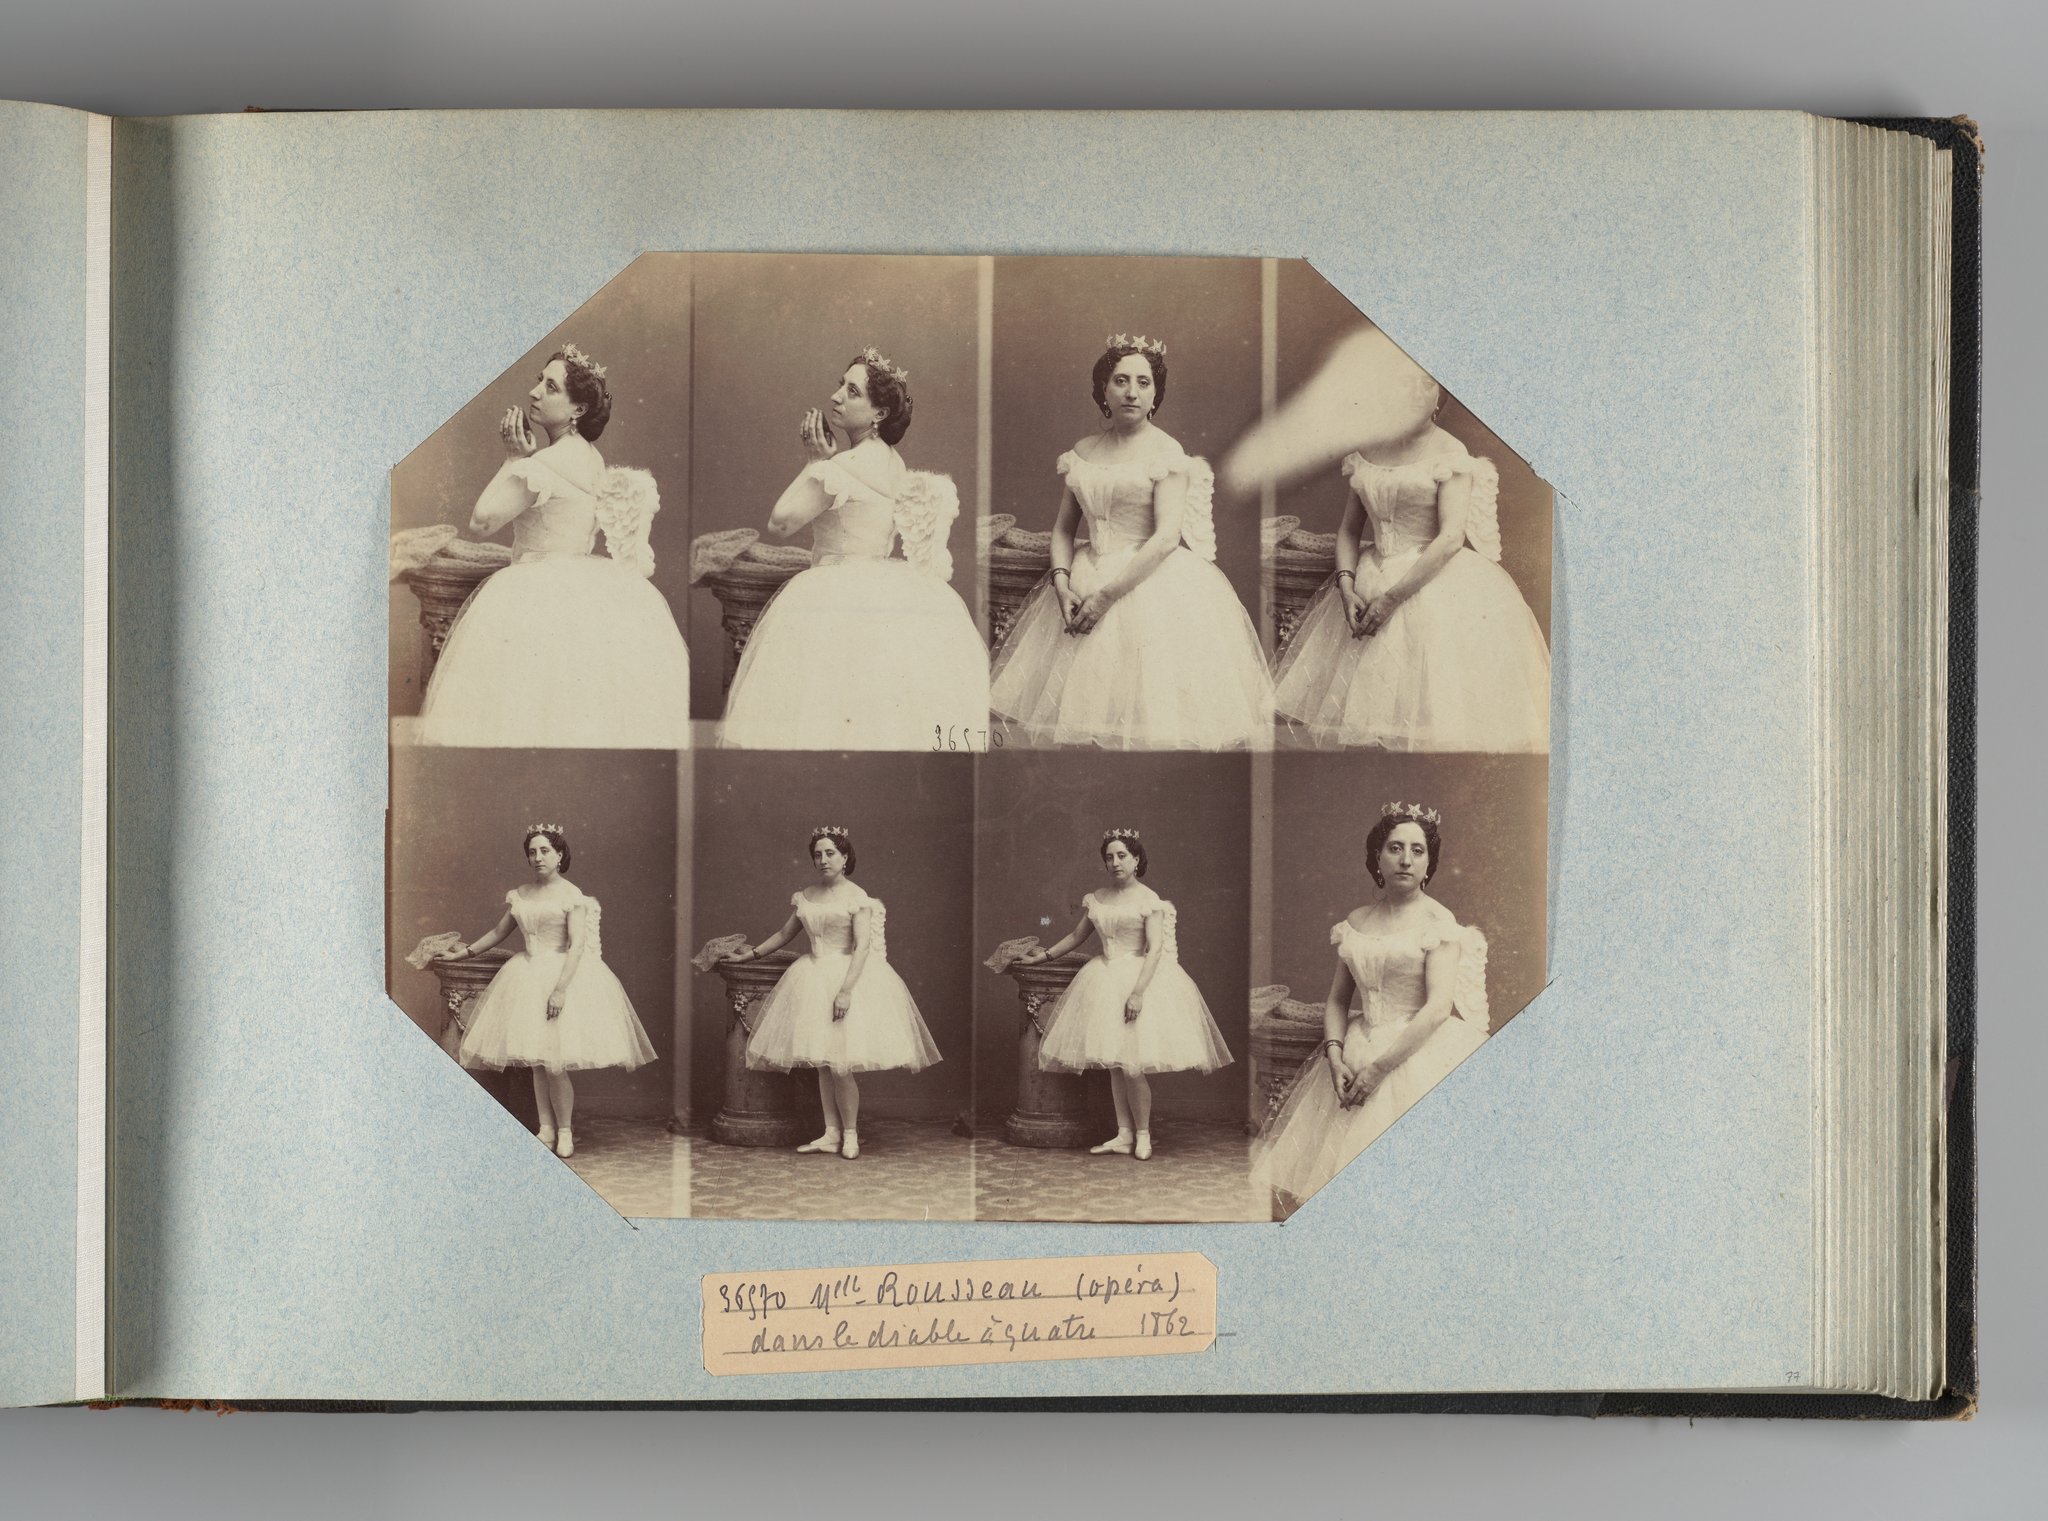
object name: photograph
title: Mlle Rousseau dans le Diable à quatre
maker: andré-adolphe-eugène disdéri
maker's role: artist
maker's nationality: french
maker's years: 1819-1889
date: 1862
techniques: albumen silver print, glass negative